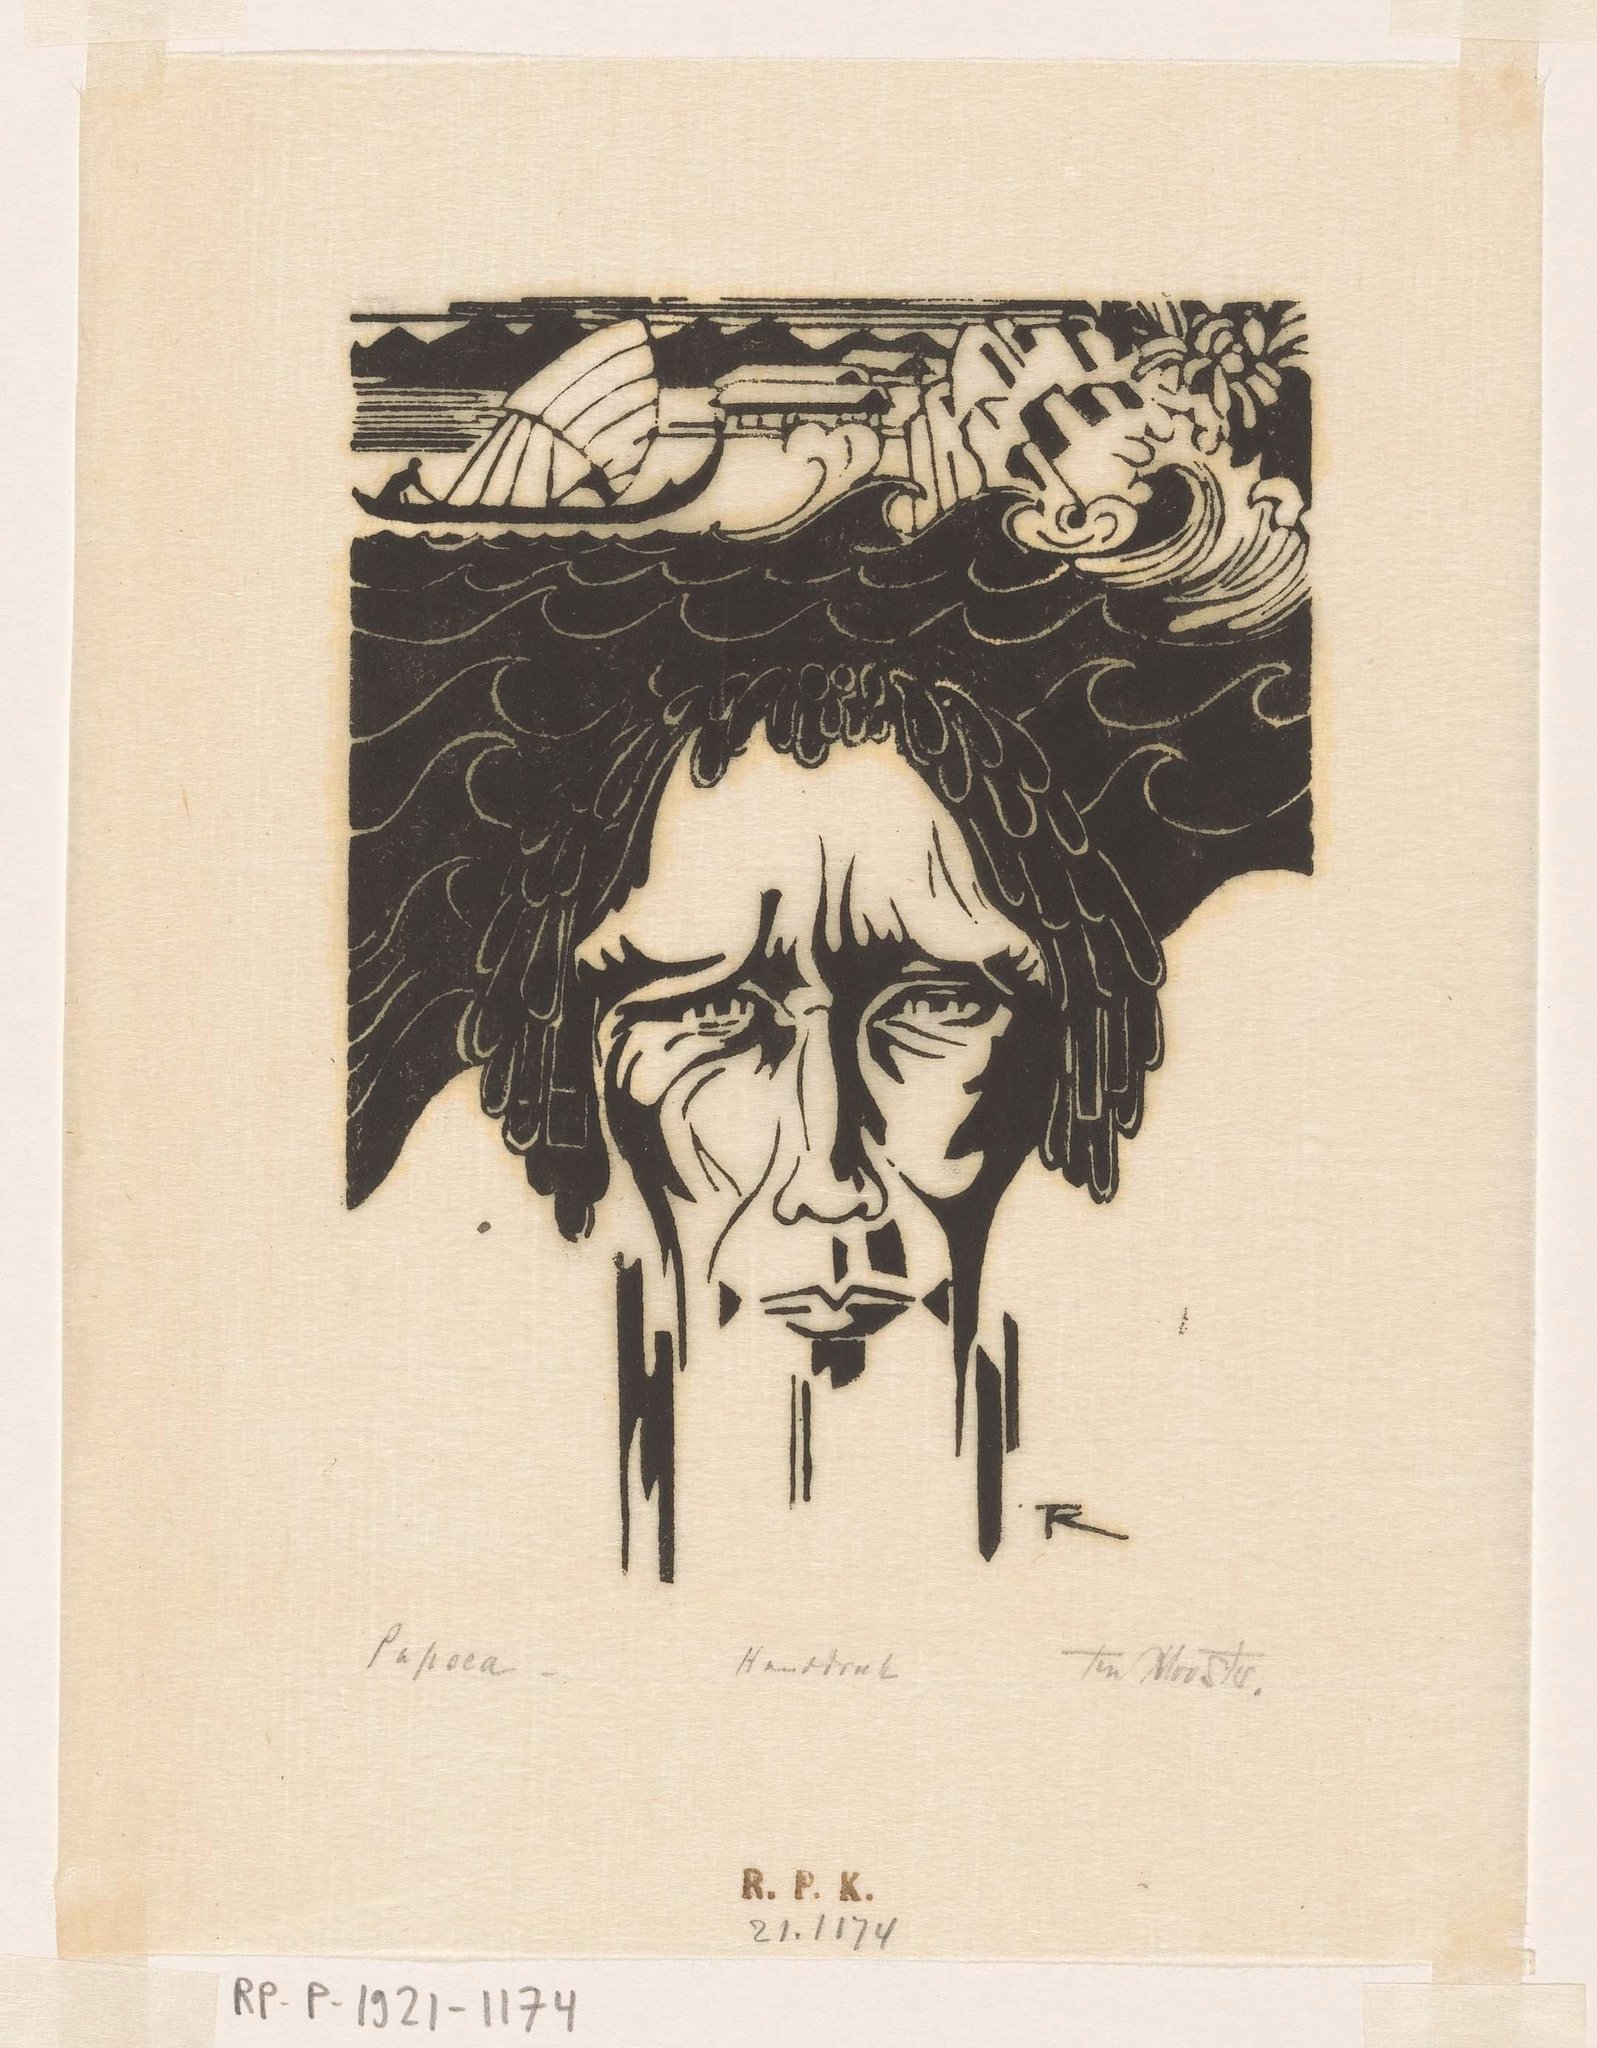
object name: print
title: Papoea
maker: johannes frederik engelbert ten klooster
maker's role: draughtsman, print maker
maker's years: 1873-1940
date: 1920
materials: paper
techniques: woodcut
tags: head (human), sailing-ship, sailing-boat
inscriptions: collector's mark: Lugt 2233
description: Het hoofd van een man. Daarboven een zeilschip op zee.